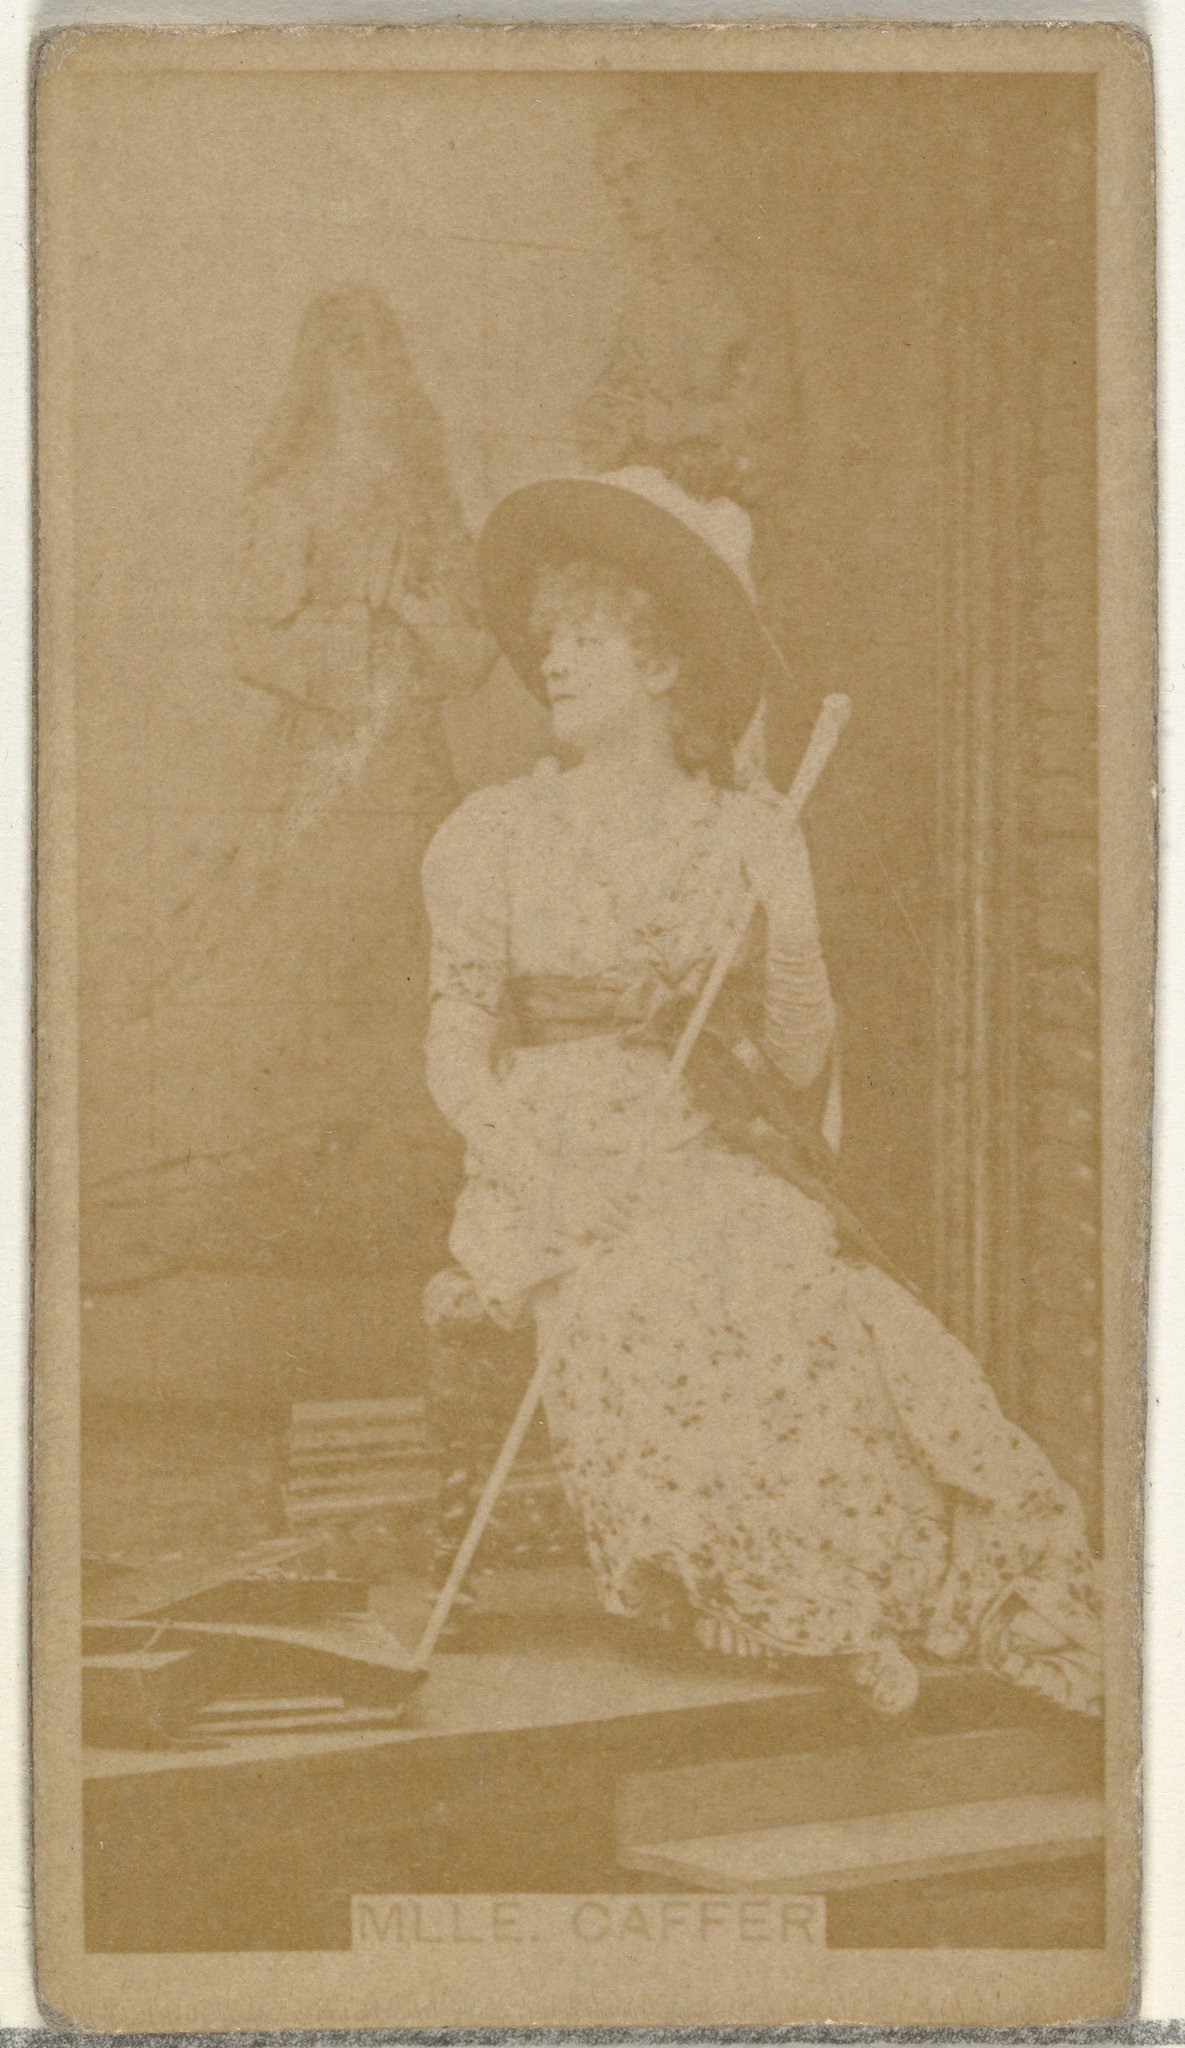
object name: photograph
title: Mlle. Caffer, from the Actors and Actresses series (N145-8) issued by Duke Sons & Co. to promote Duke Cigarettes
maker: w. duke, sons & co.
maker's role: publisher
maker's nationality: american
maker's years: 1870-1920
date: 1891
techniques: albumen silver print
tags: portraits,women,actresses